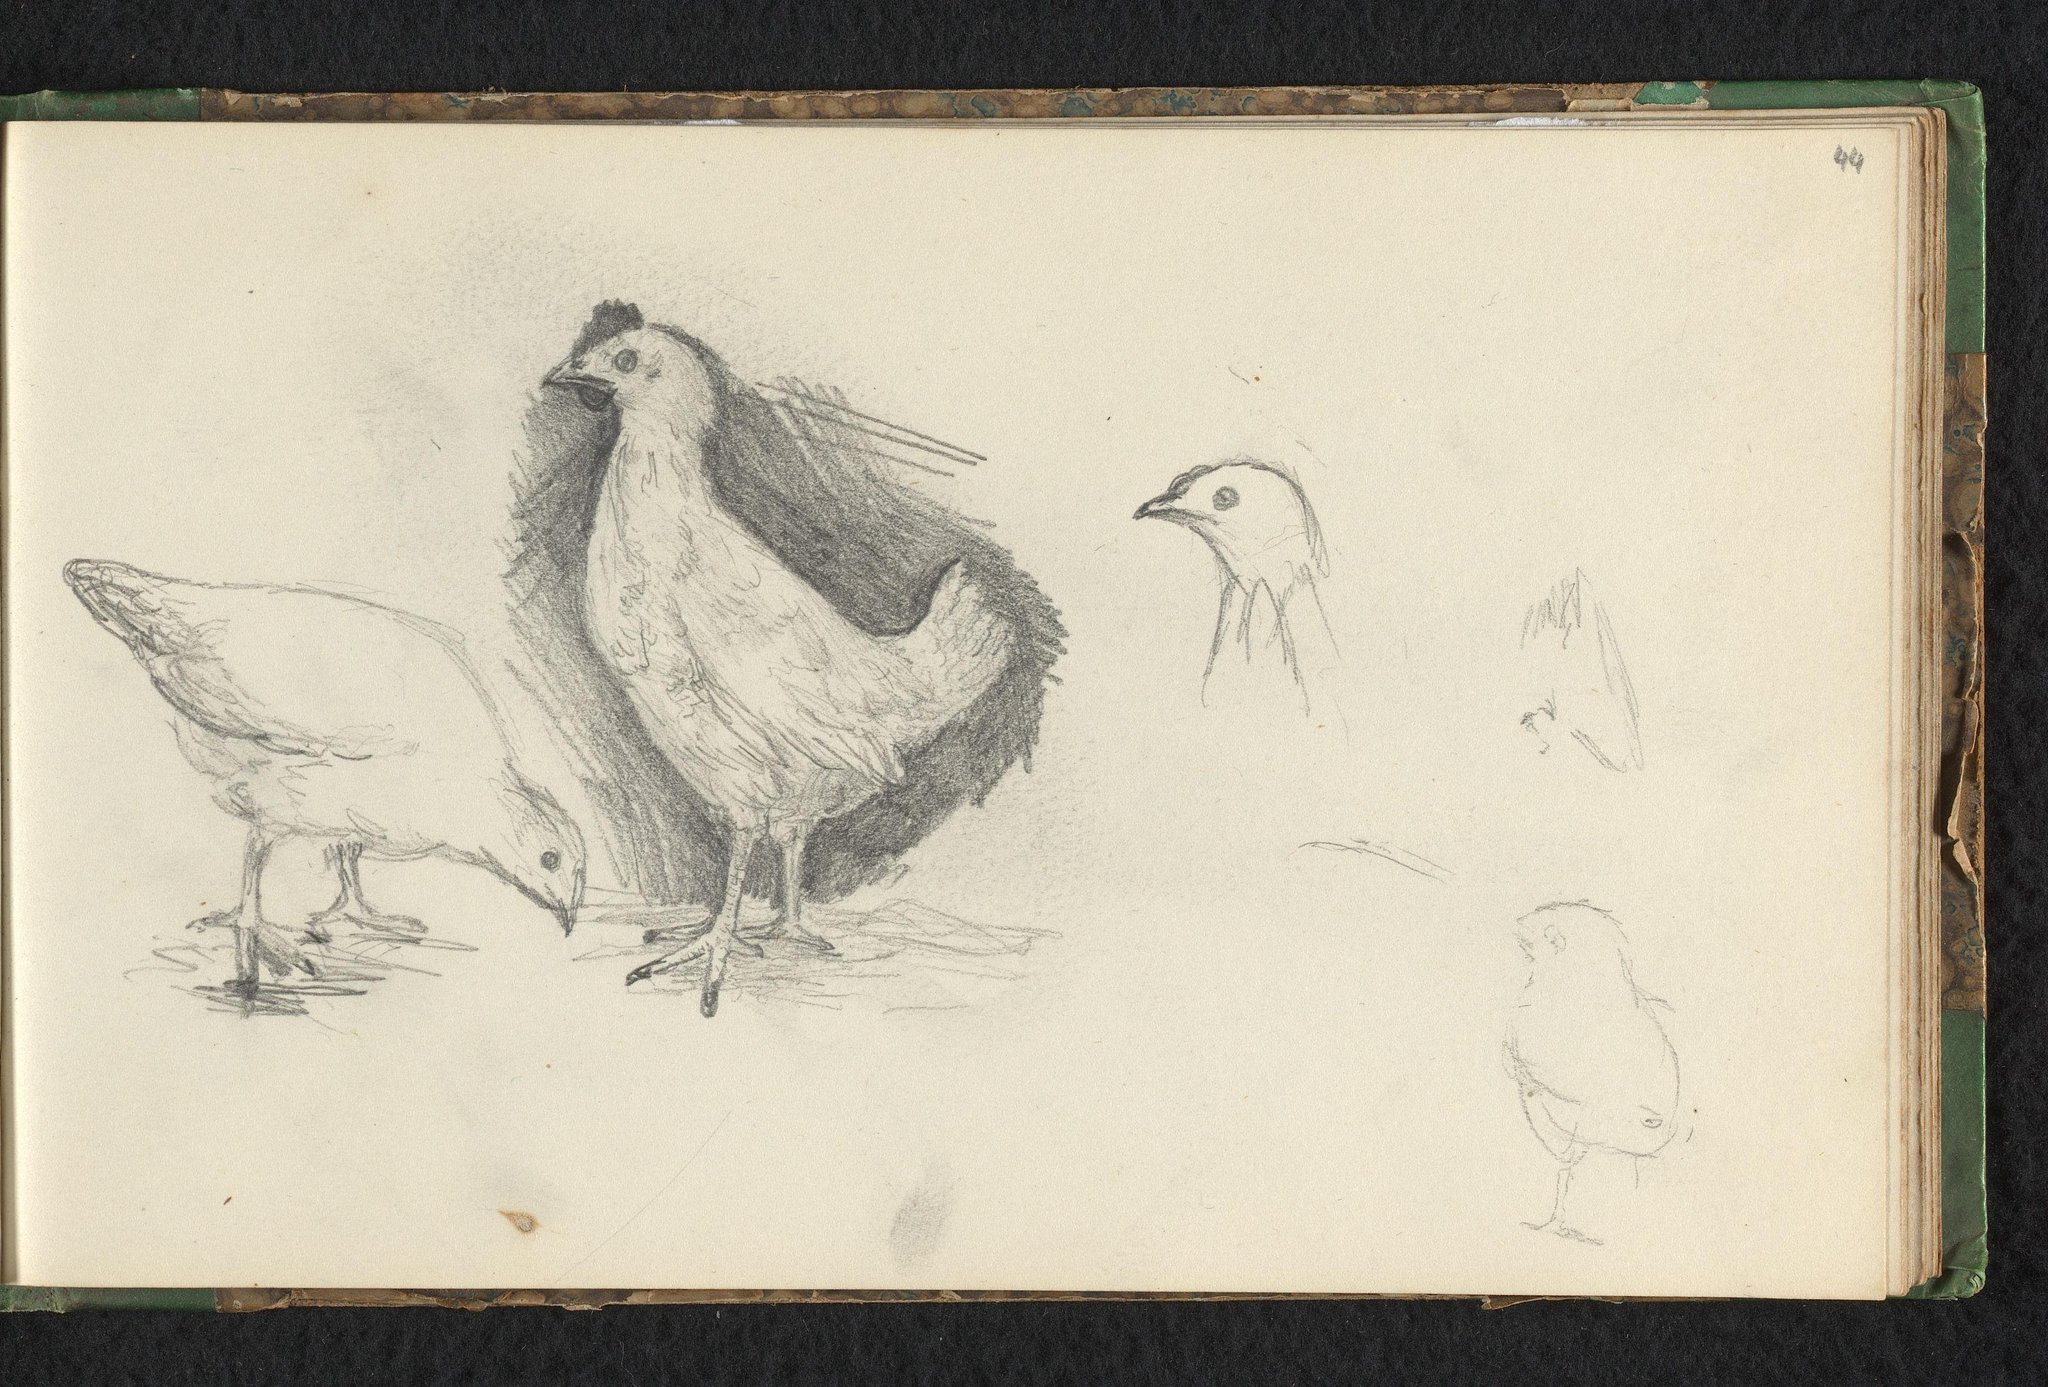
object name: sketchbook leaf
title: Vier kippen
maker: jan bedijs tom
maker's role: draughtsman, painter, print maker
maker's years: 1813-1894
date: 1823-1894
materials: paper, pencil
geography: the hague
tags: fowl (cock, hen, chicken, etc.)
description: Pagina 44 recto uit een schetsboek met 61 bladen.